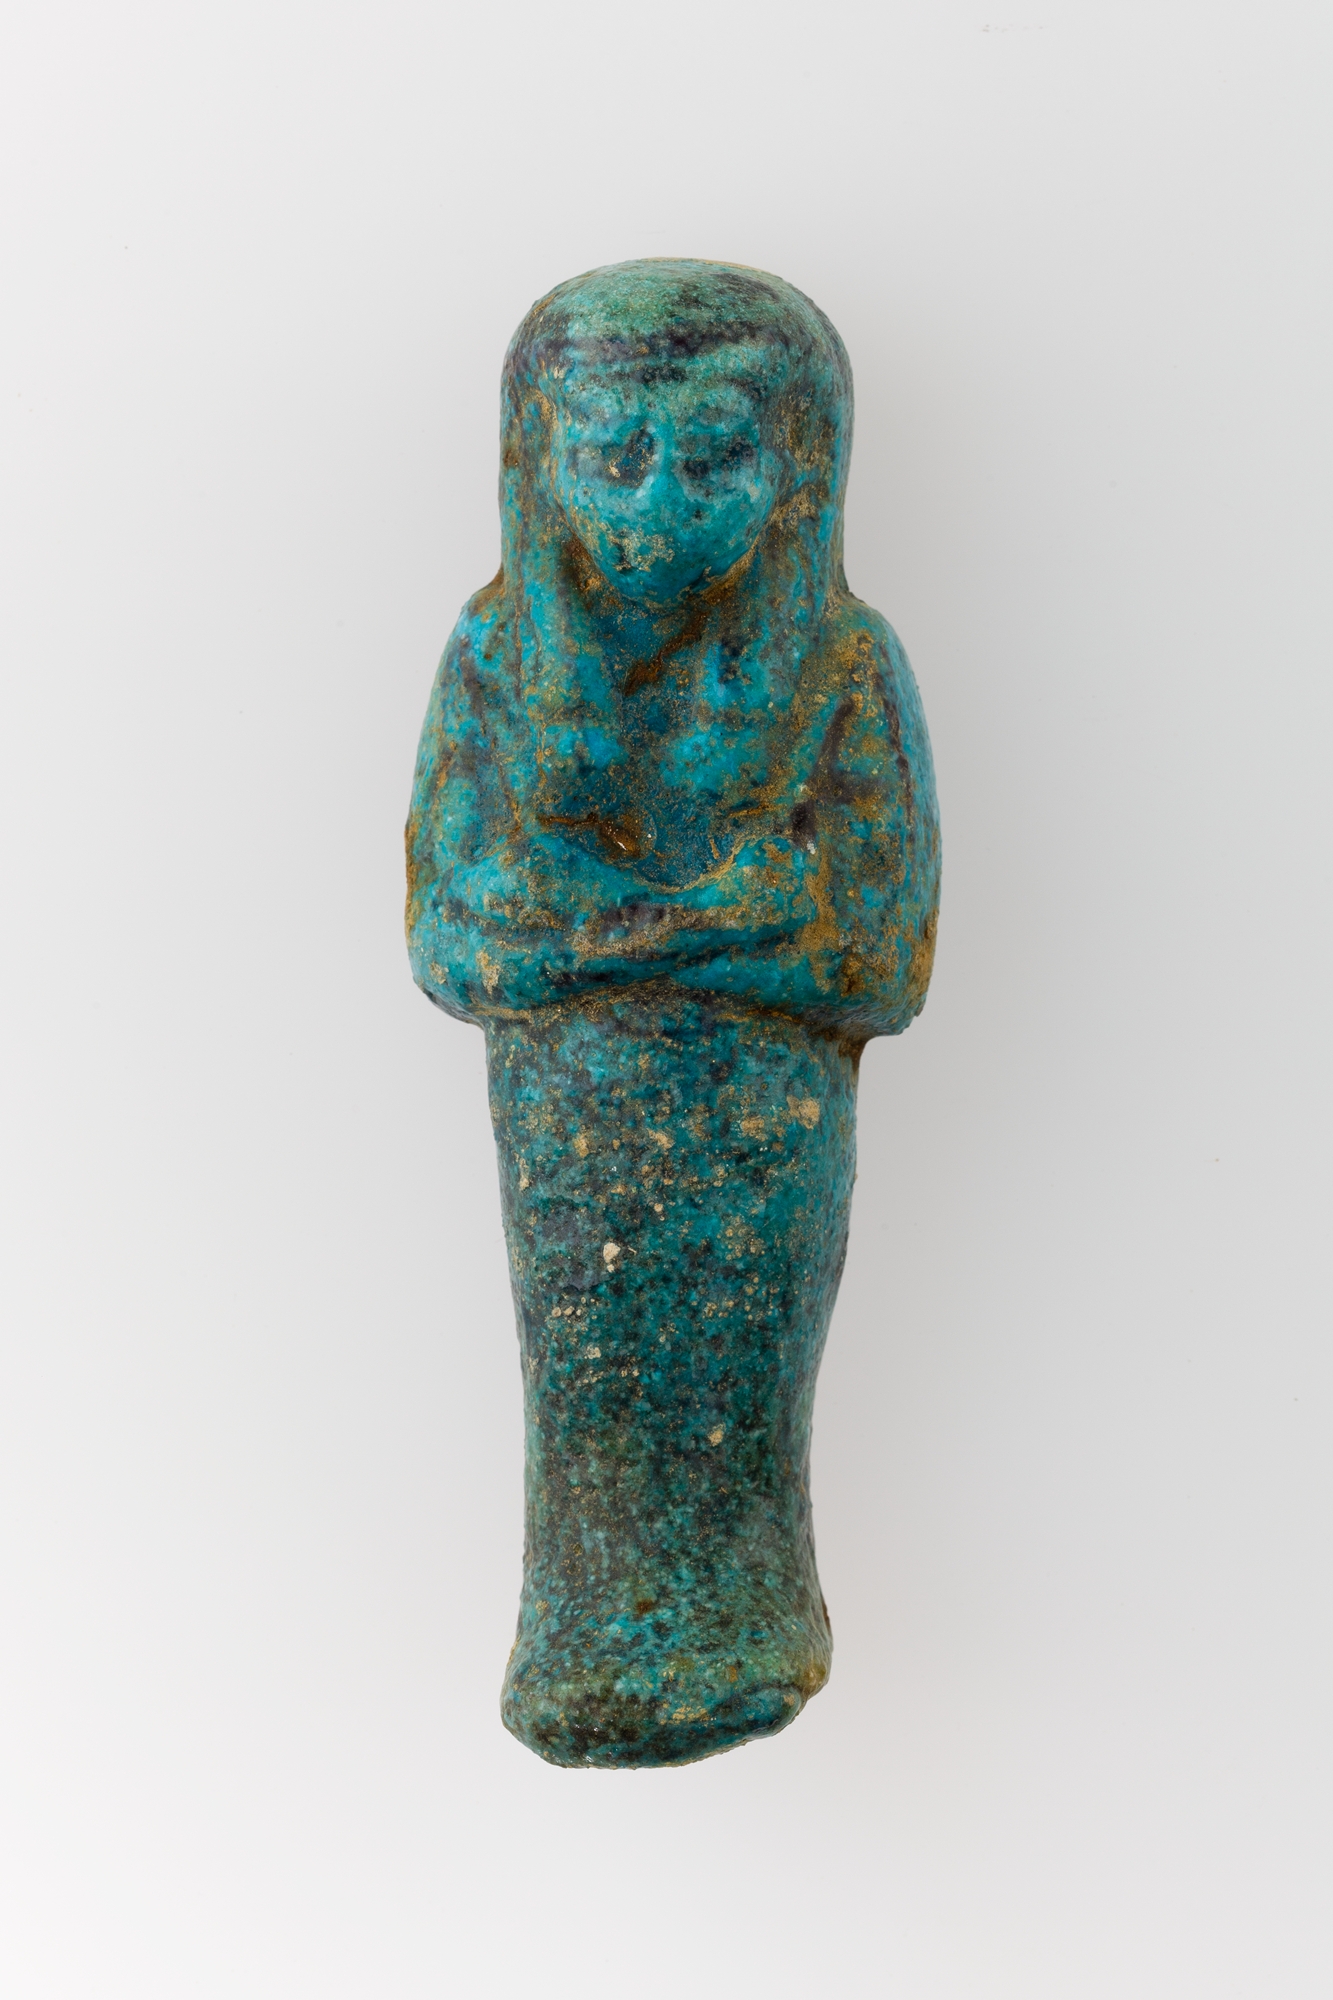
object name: shabti, henettawy c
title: Worker Shabti of Henettawy (C), Daughter of Isetemkheb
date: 990-970 BCE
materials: faience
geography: egypt